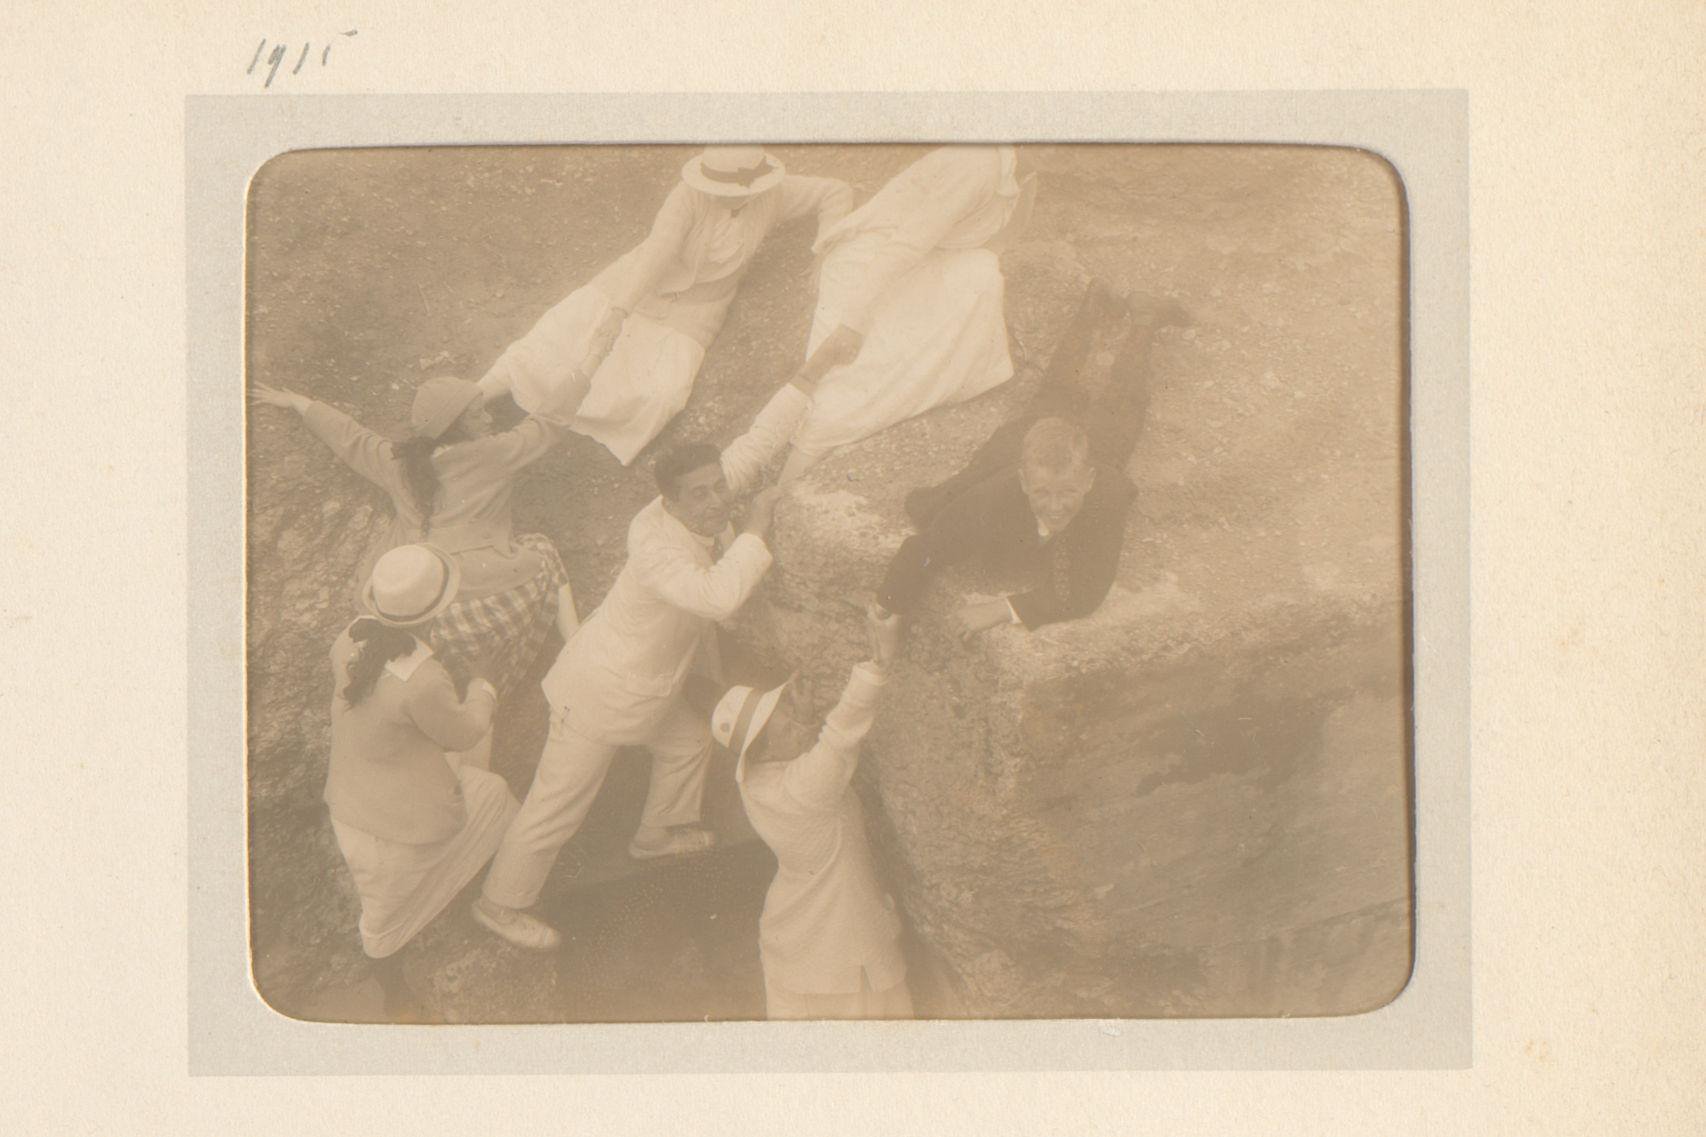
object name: album leaf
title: Gezelschap klimt naar boven vanuit een kuil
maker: liesbeth overhoff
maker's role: fotograaf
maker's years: 1895-1969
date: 1915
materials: paper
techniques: gelatin silver print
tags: climbing, historical persons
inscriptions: inscription: ‘1915’